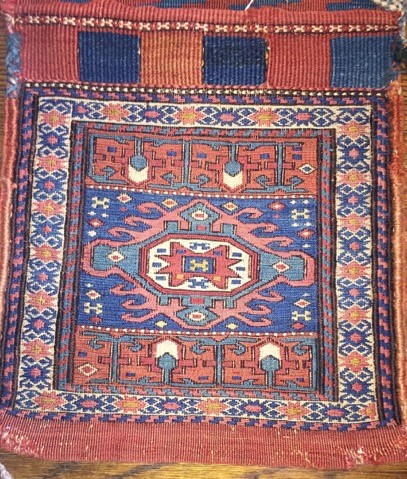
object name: saddle bag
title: Shahsevan Double Saddle Bag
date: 1860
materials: cotton, wool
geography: iran